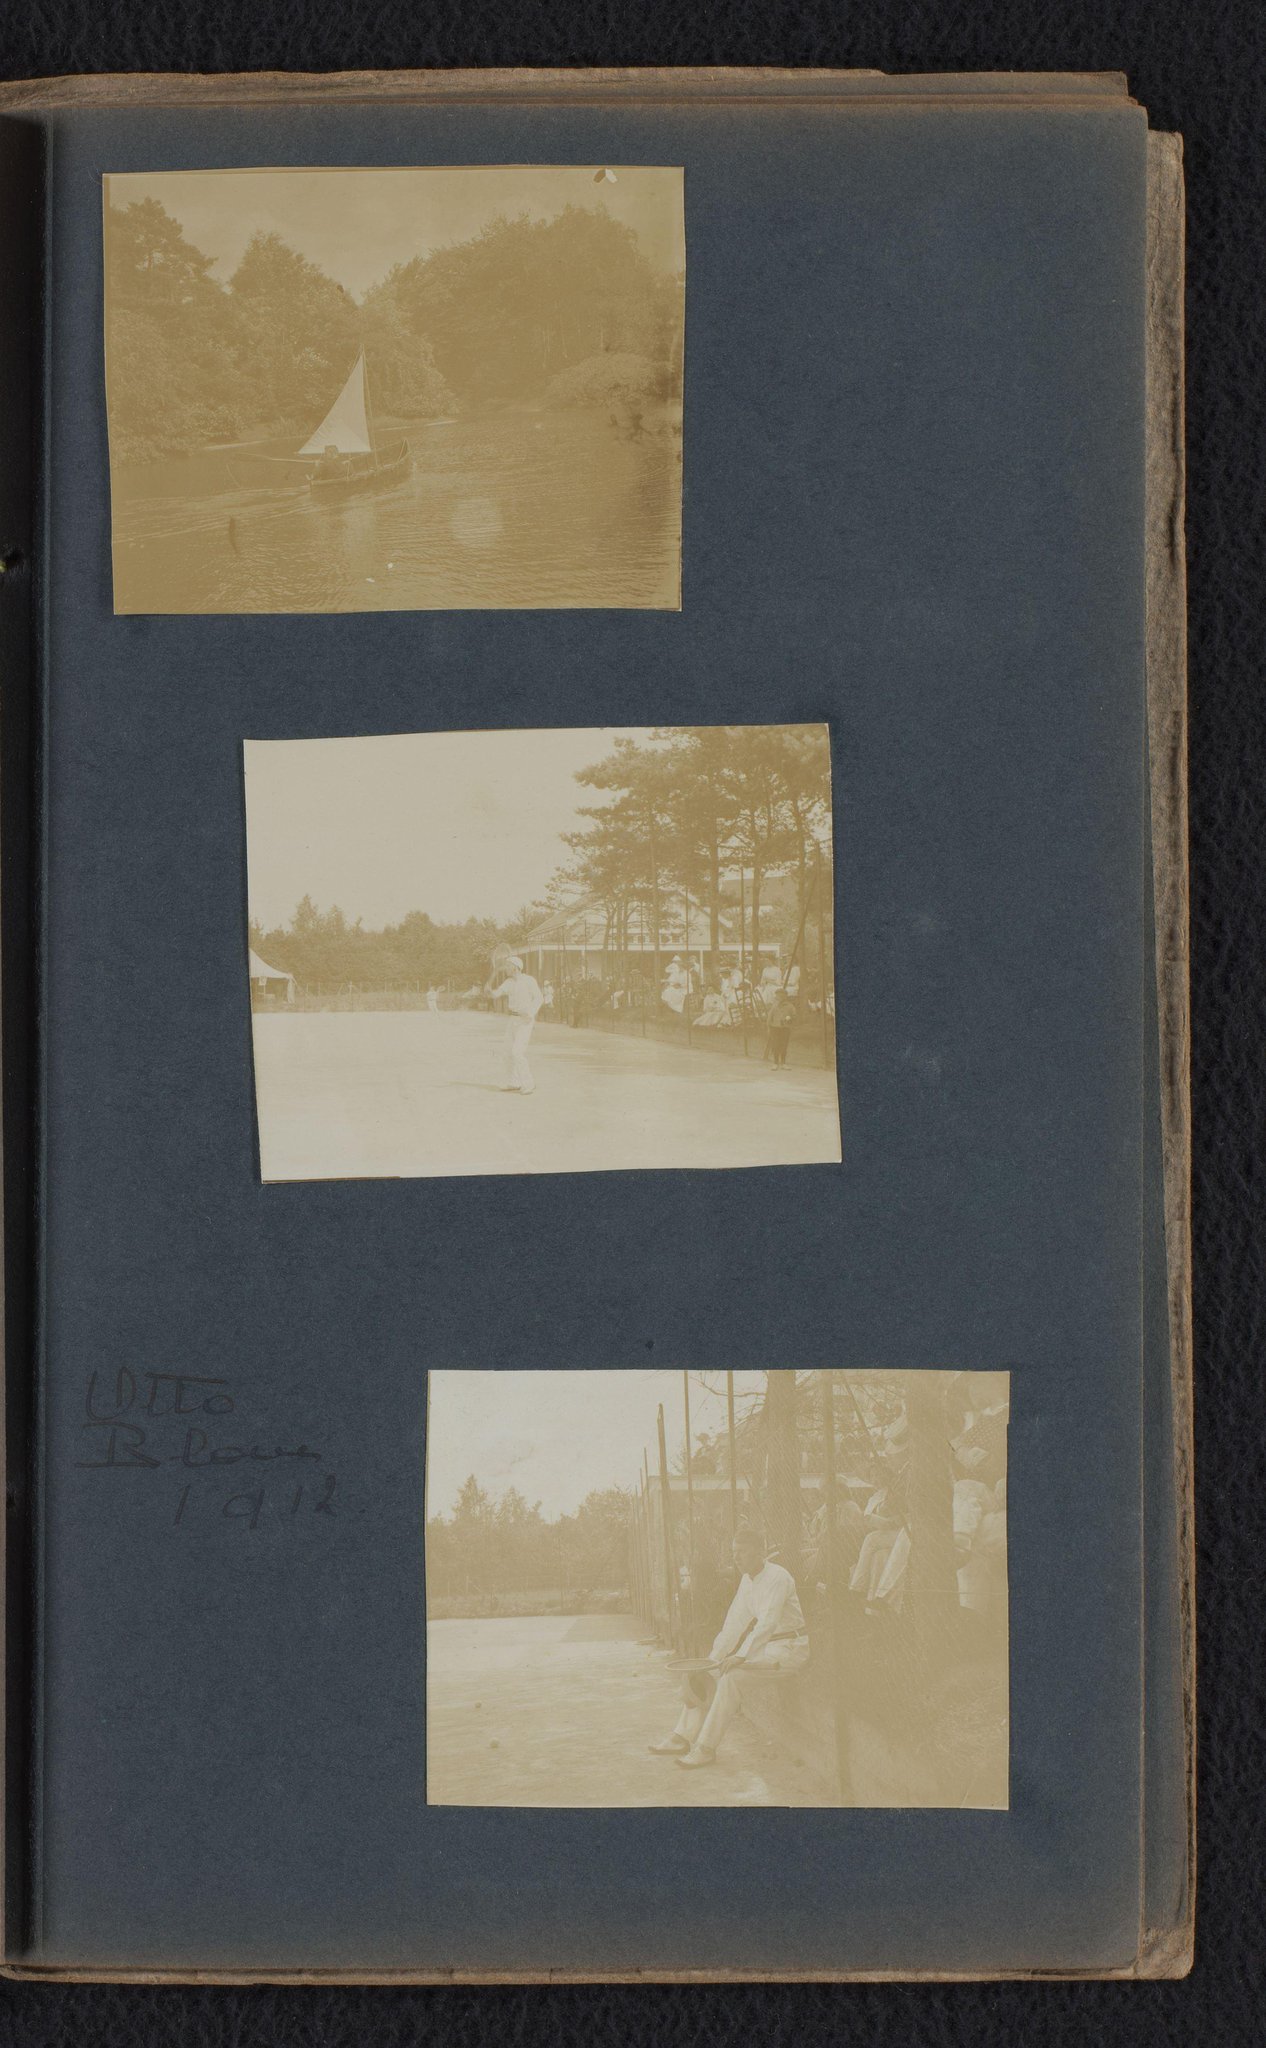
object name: photograph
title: Onbekende jongen in een zeilboot, en Otto Blau tijdens een tenniswedstrijd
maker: carolina frederika onnen (lien/loen)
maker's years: 1896-1983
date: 1912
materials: paper, cardboard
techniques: collodion silver print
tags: tennis, lawn-tennis, sailing-ship, sailing-boat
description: Deze foto's zijn onderdeel van een album.